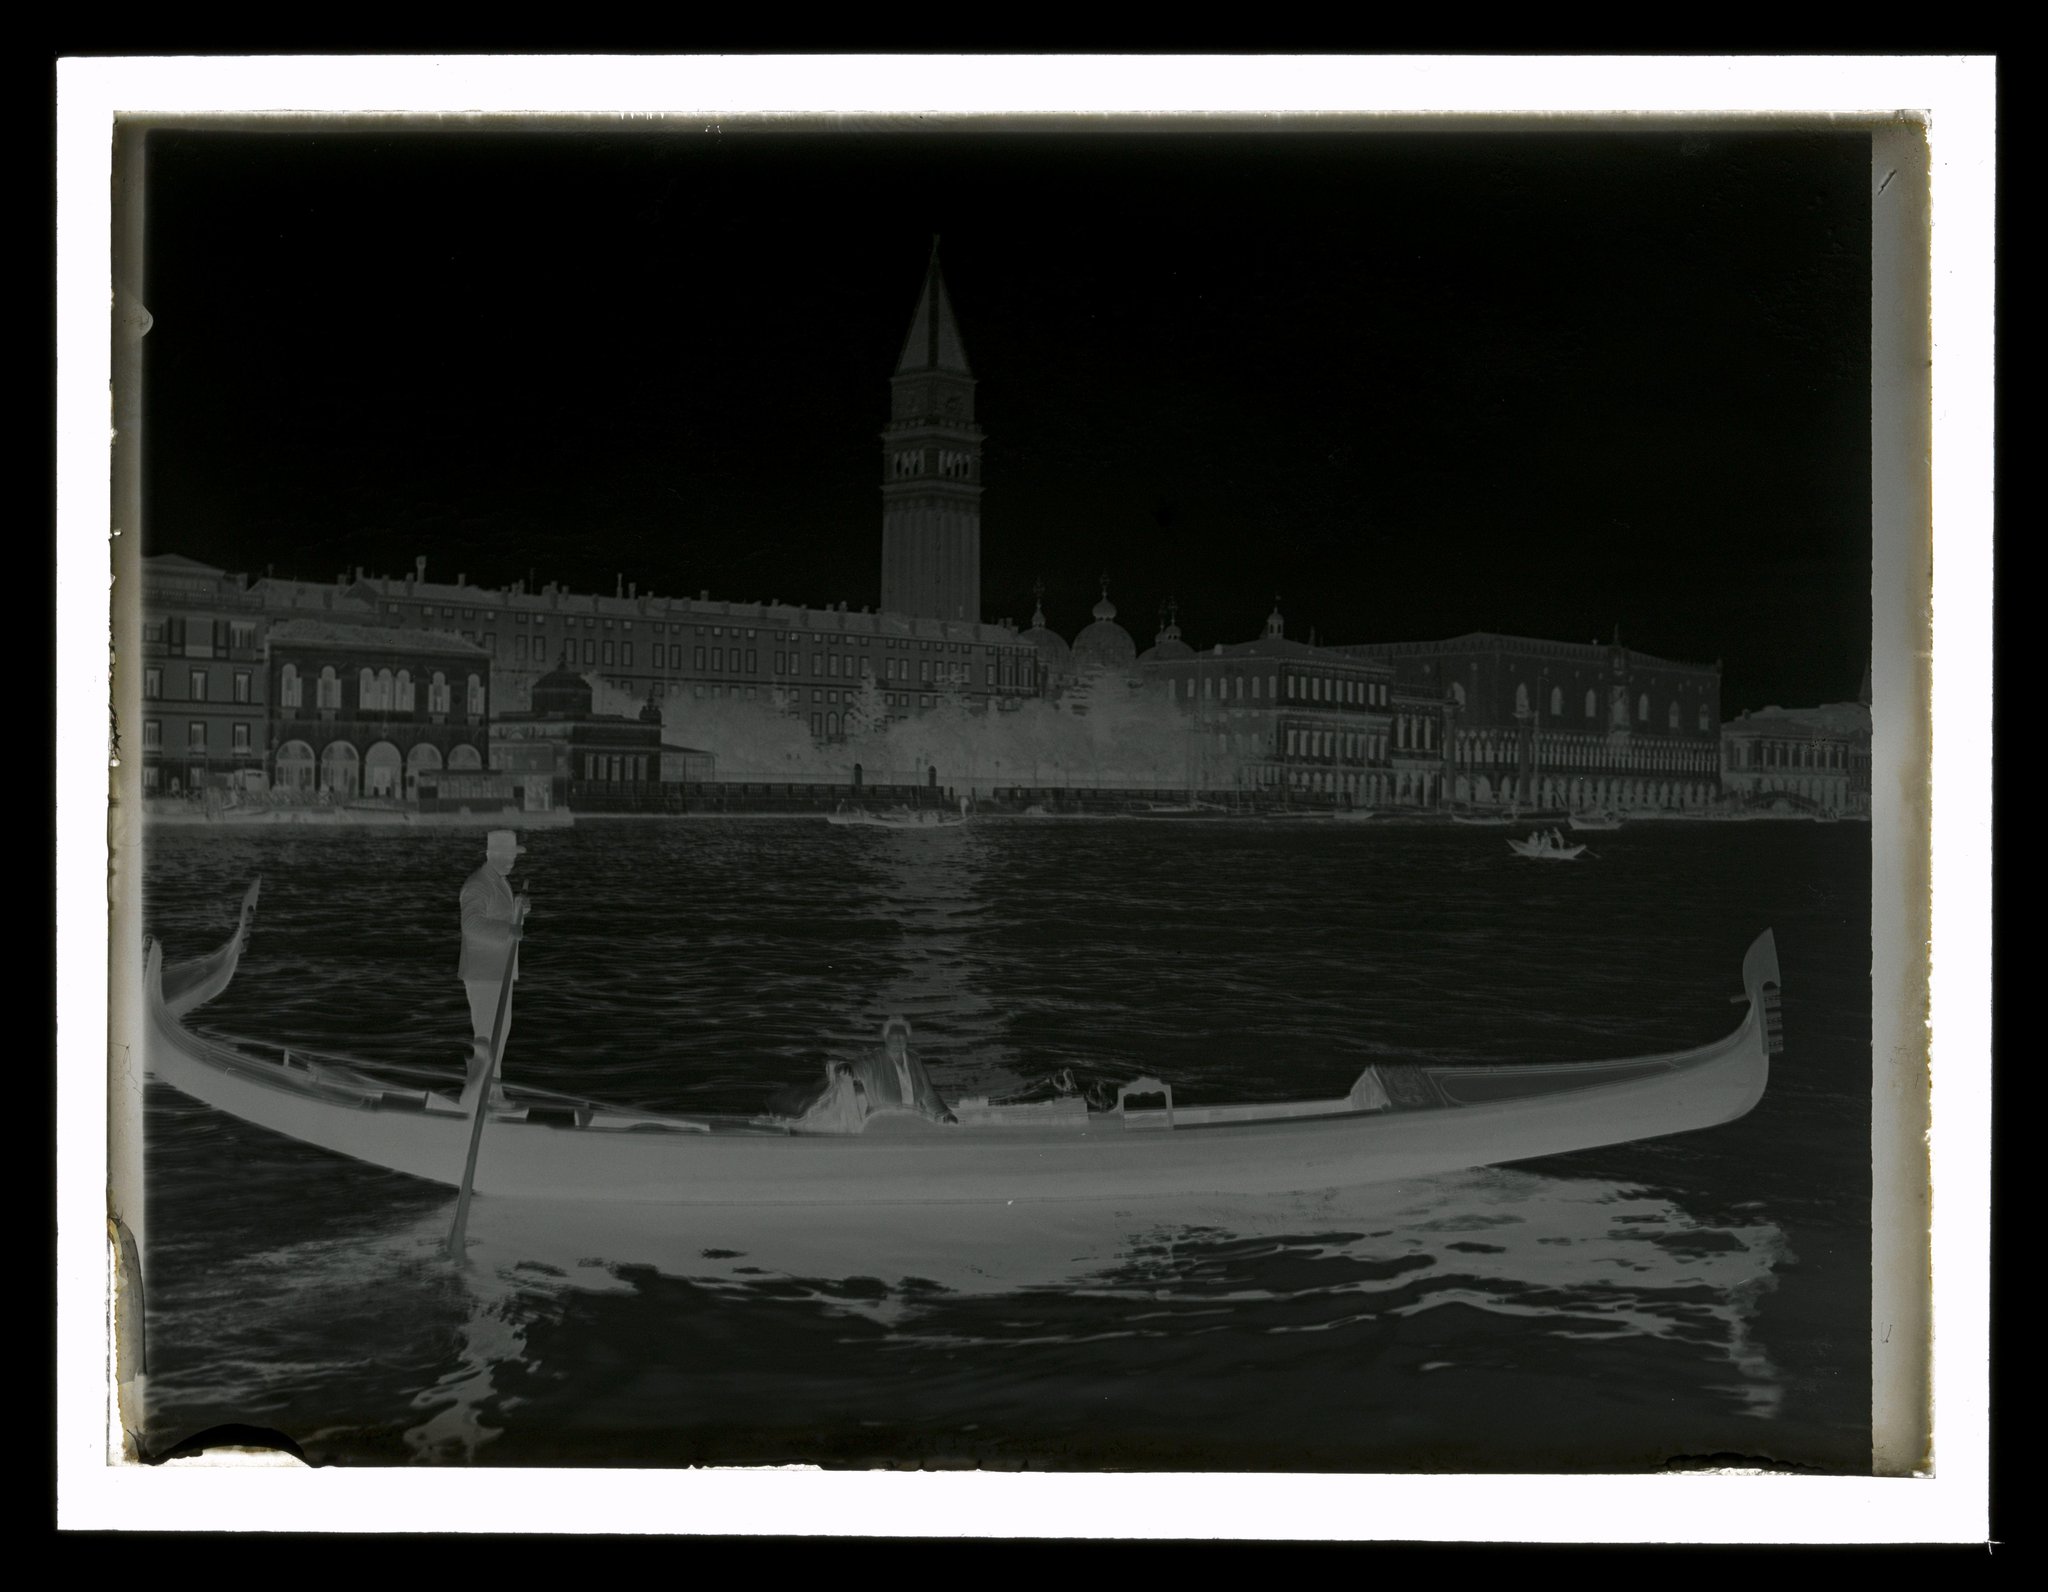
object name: glasnegatief, glasplaatnegatief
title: Gondel in Venetië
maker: Anonymous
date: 1907-1935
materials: glass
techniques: gelatin glass negative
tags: gondola, venice